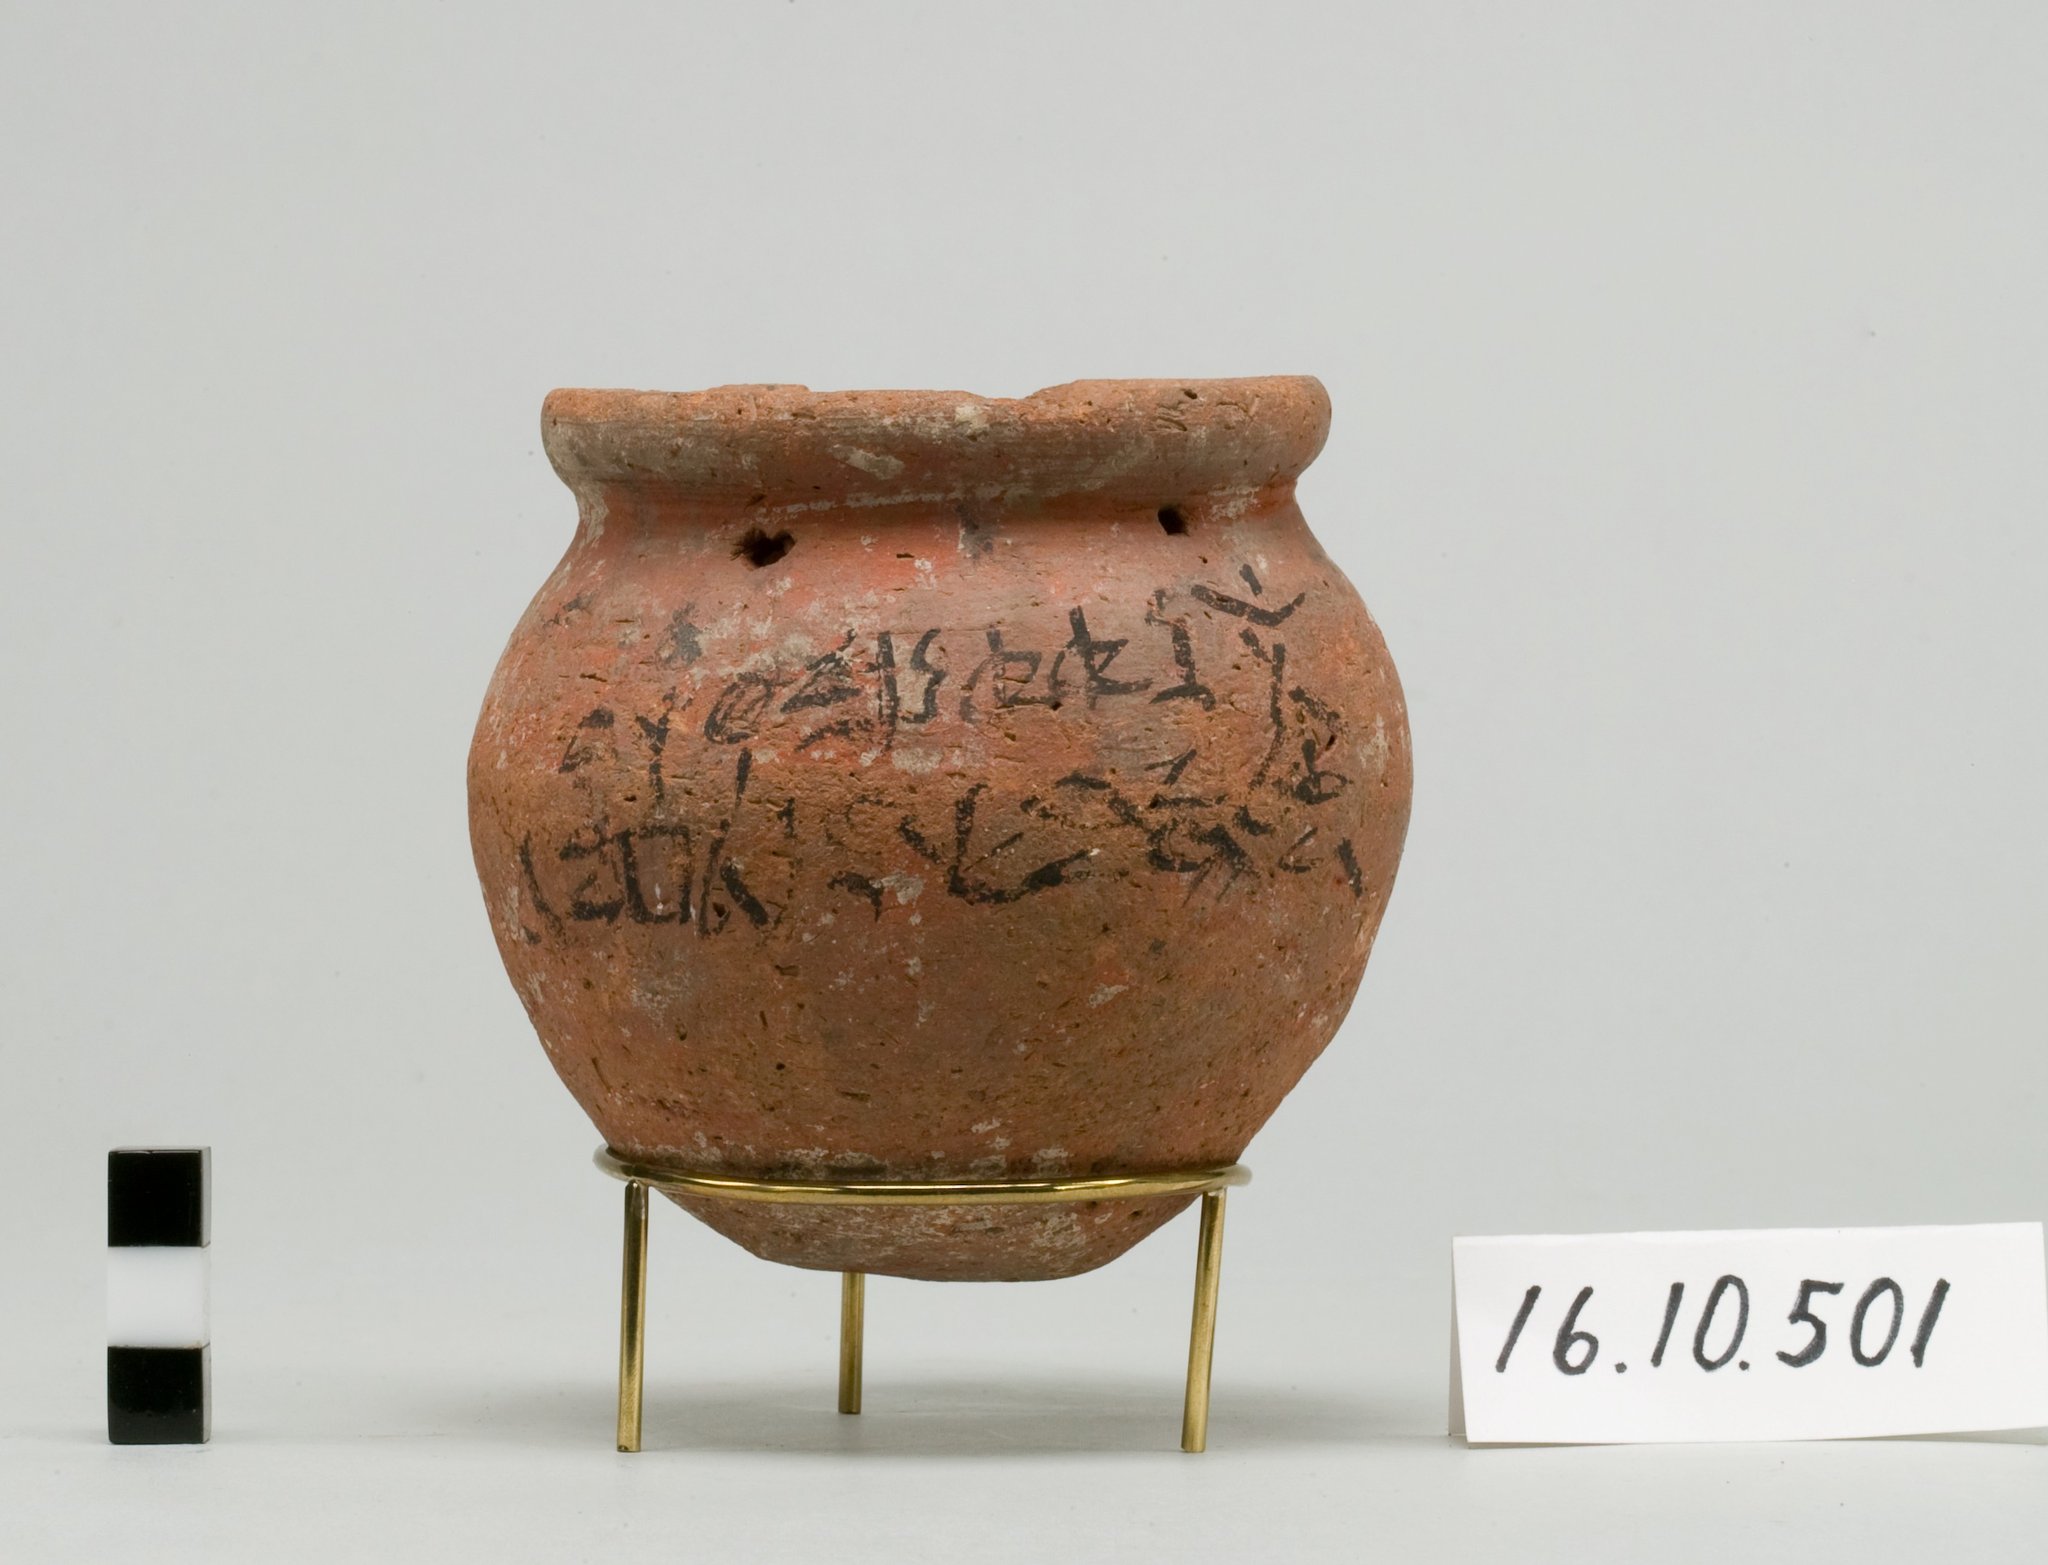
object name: jar, painted, inscribed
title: Jar With Hieratic Inscription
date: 1550-1458 BCE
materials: paint, pottery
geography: egypt